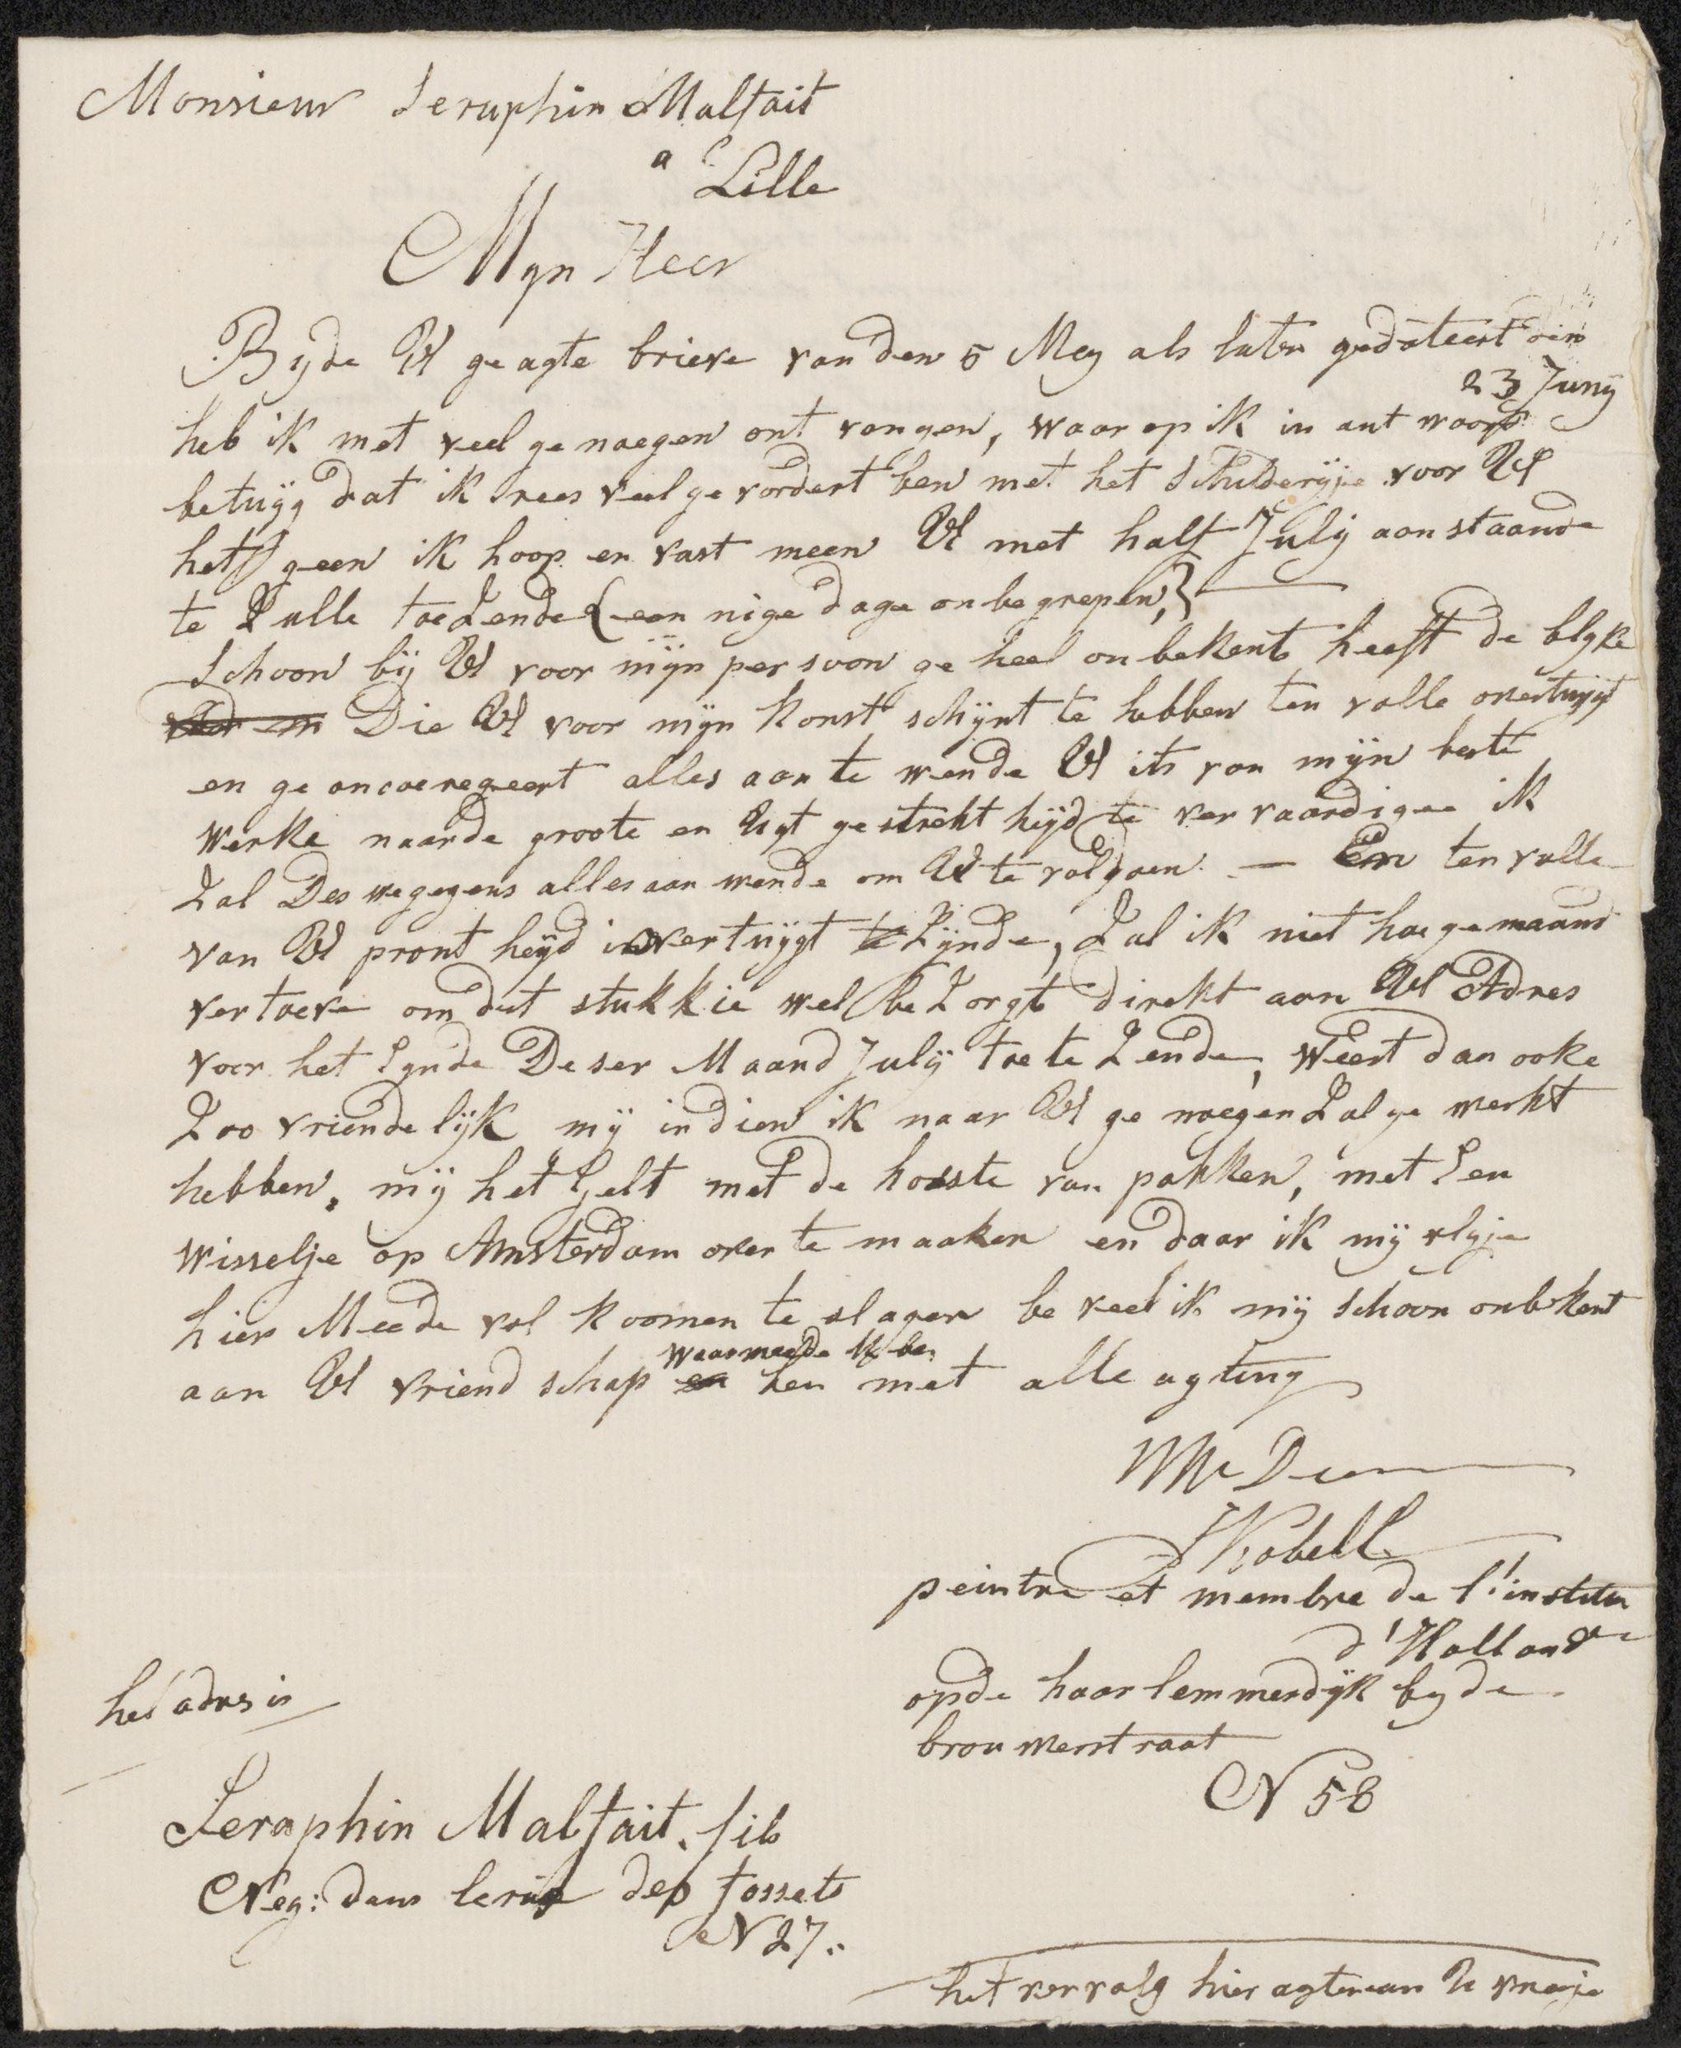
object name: letter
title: Brief aan Séraphin Malfait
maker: jan kobell (ii)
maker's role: draughtsman, painter, print maker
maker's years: 1778-1814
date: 1787-1814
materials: ink, paper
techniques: pen, writing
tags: family life, painting (including book-illumination, miniature-painting), money, lille, amsterdam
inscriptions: watermark, seal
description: Brief bevat verso brief van Jan Kobell (II) aan Filippus Sundorff.